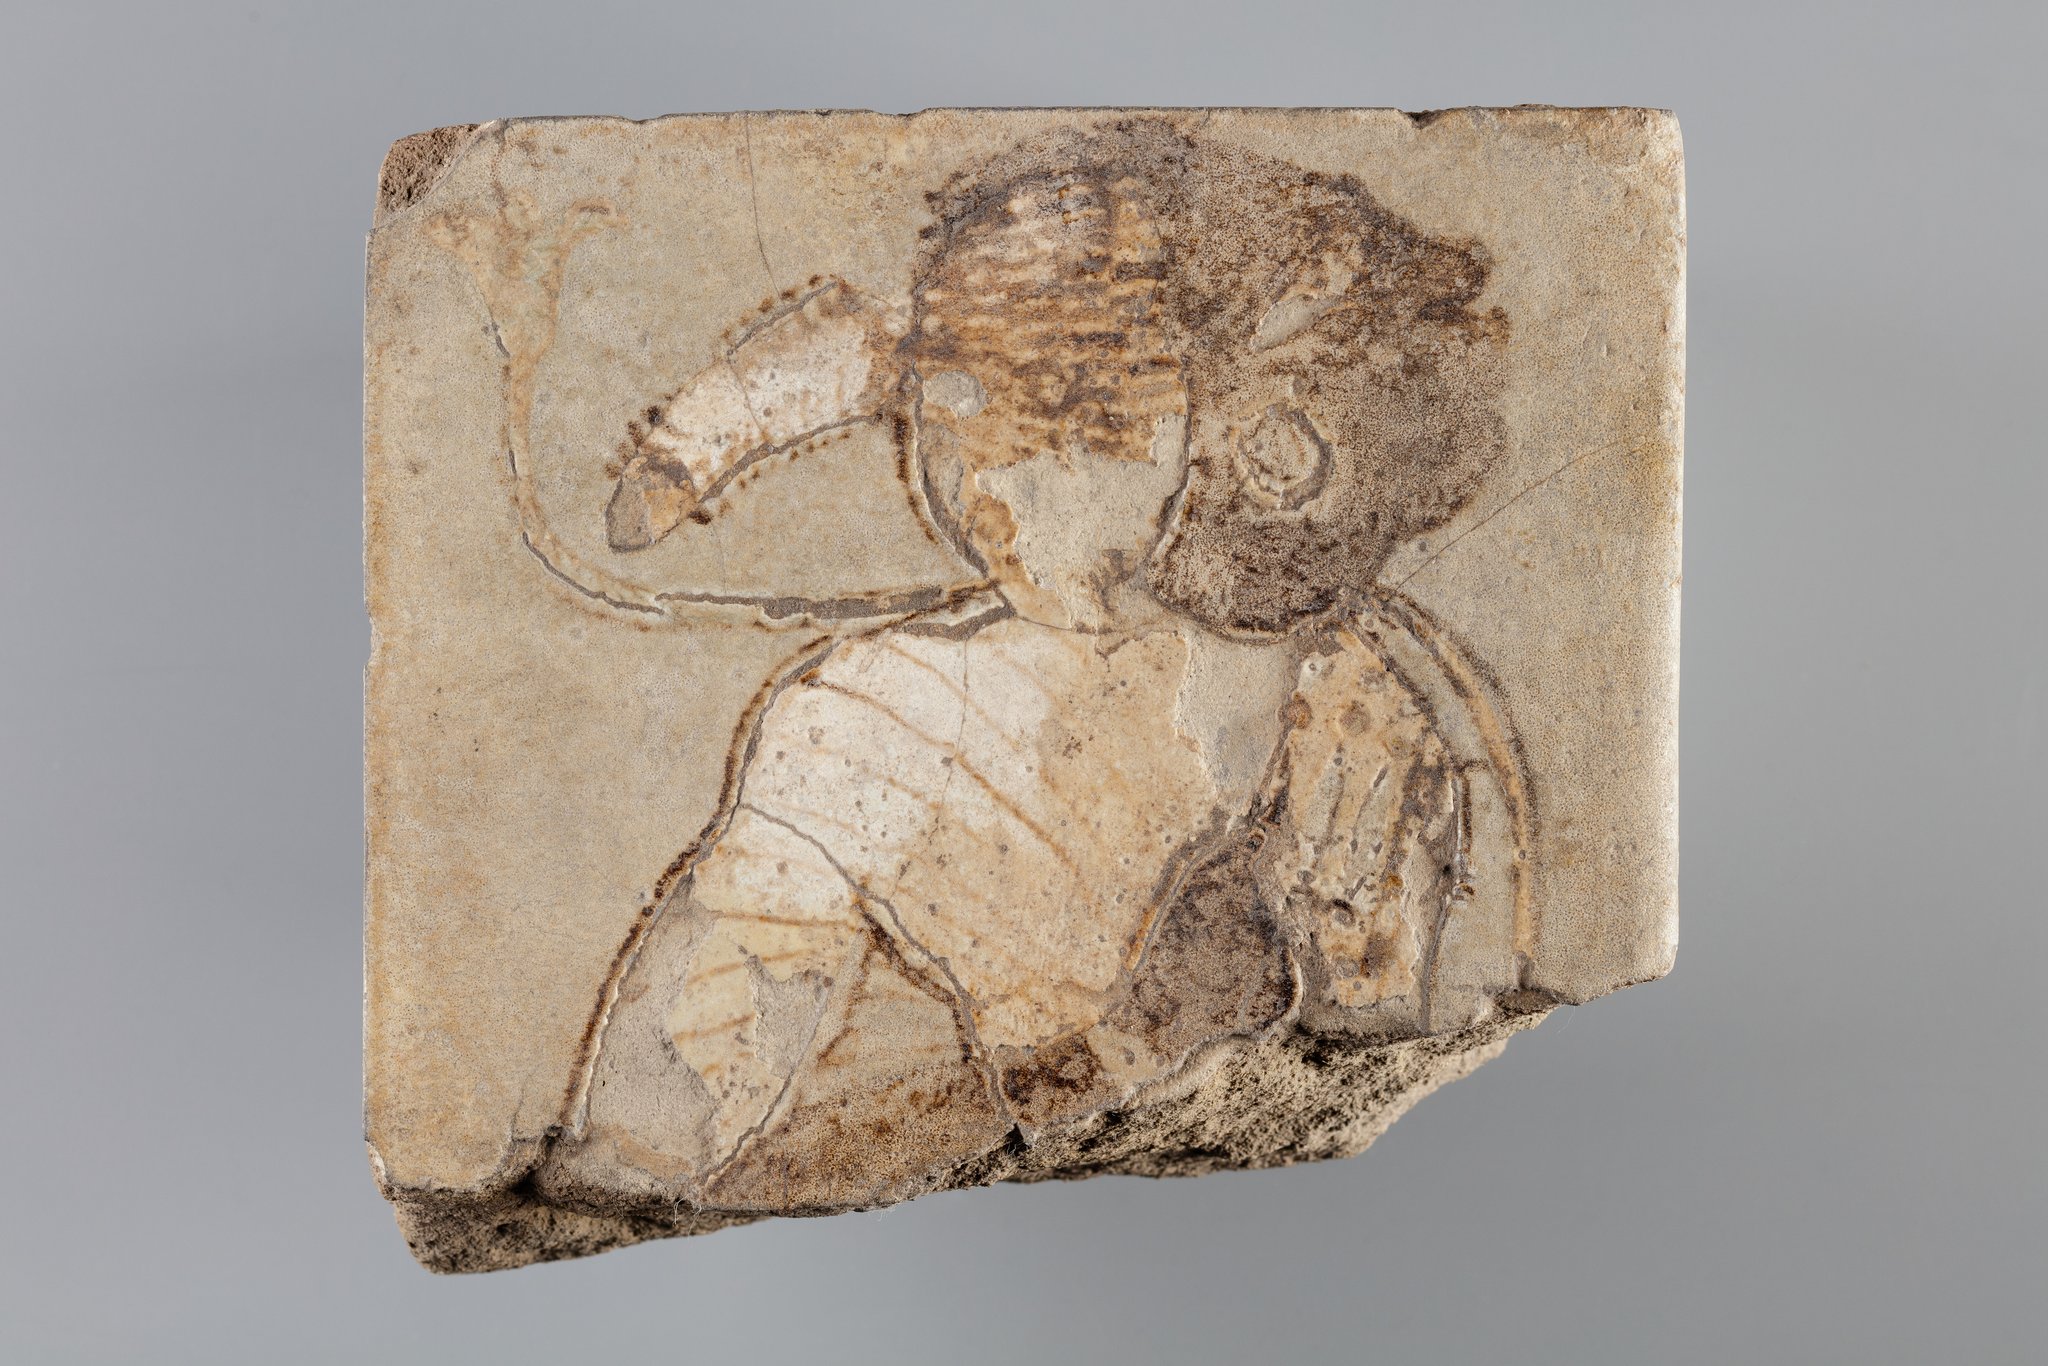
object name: tile inlay, palace of ramesses ii, foreigner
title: Tile with a bound Nubian from the the side of a dais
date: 1279-1213 BCE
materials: faience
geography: egypt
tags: men